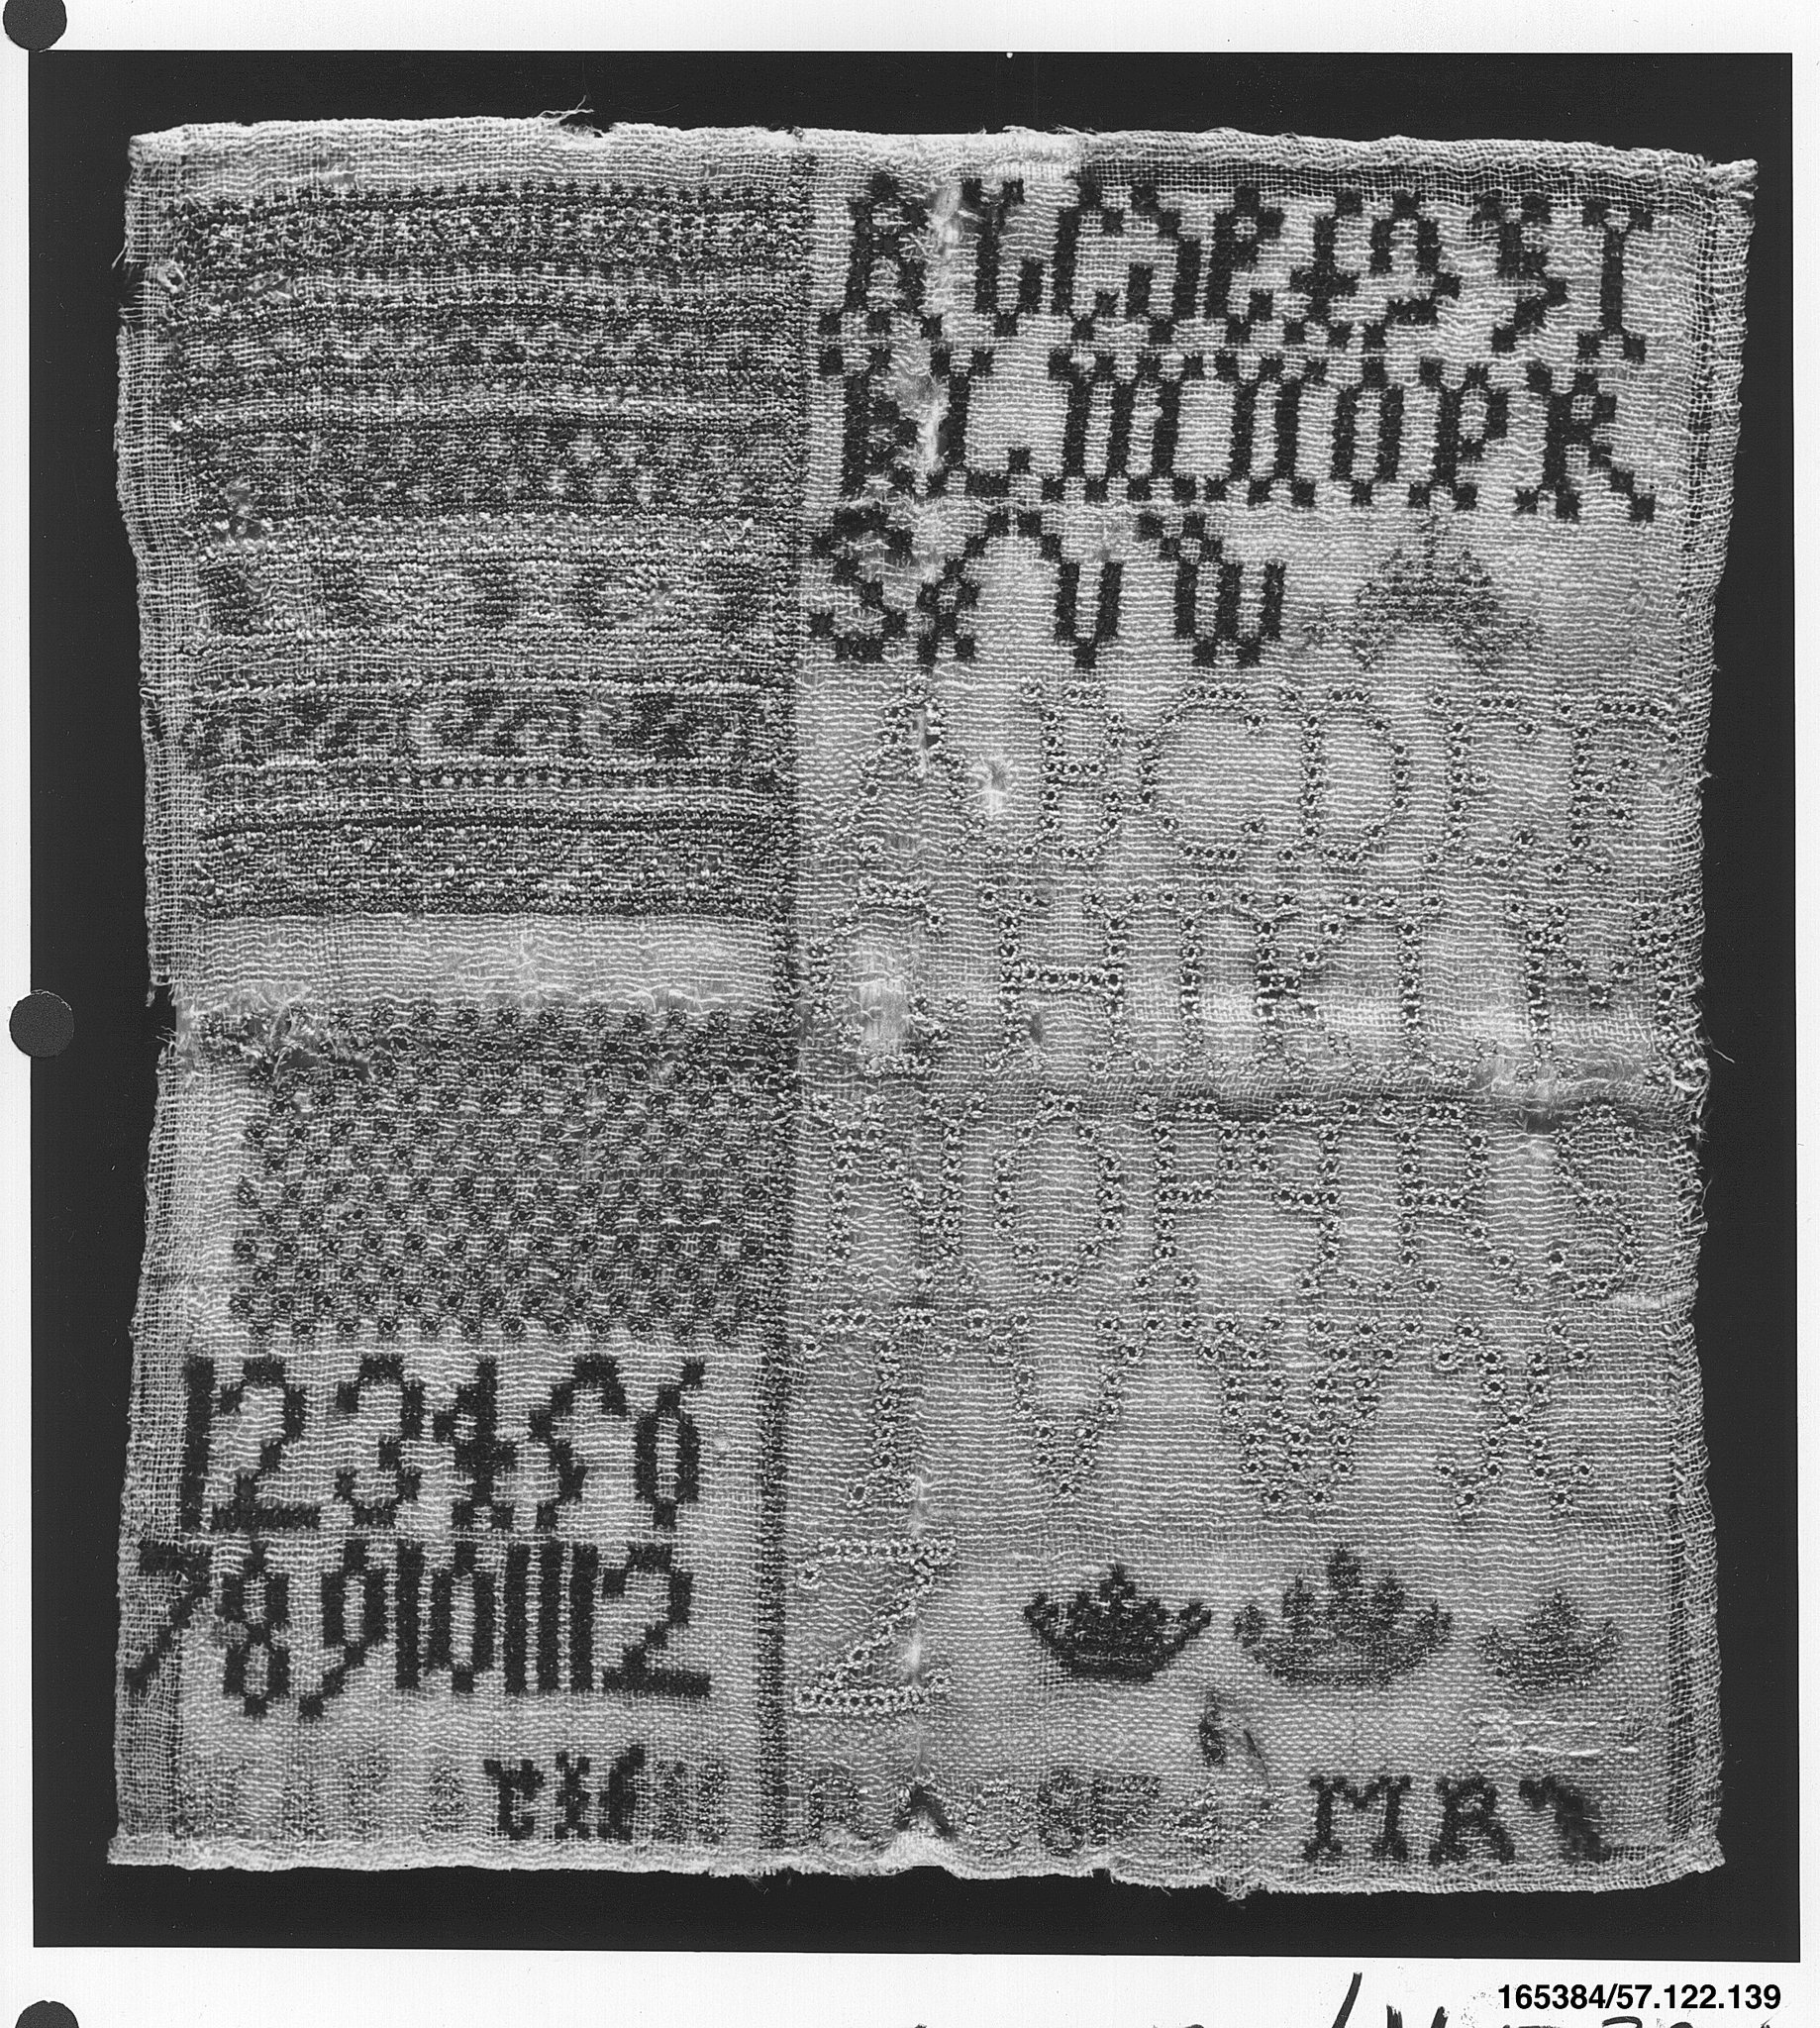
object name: sampler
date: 1747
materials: silk, wool